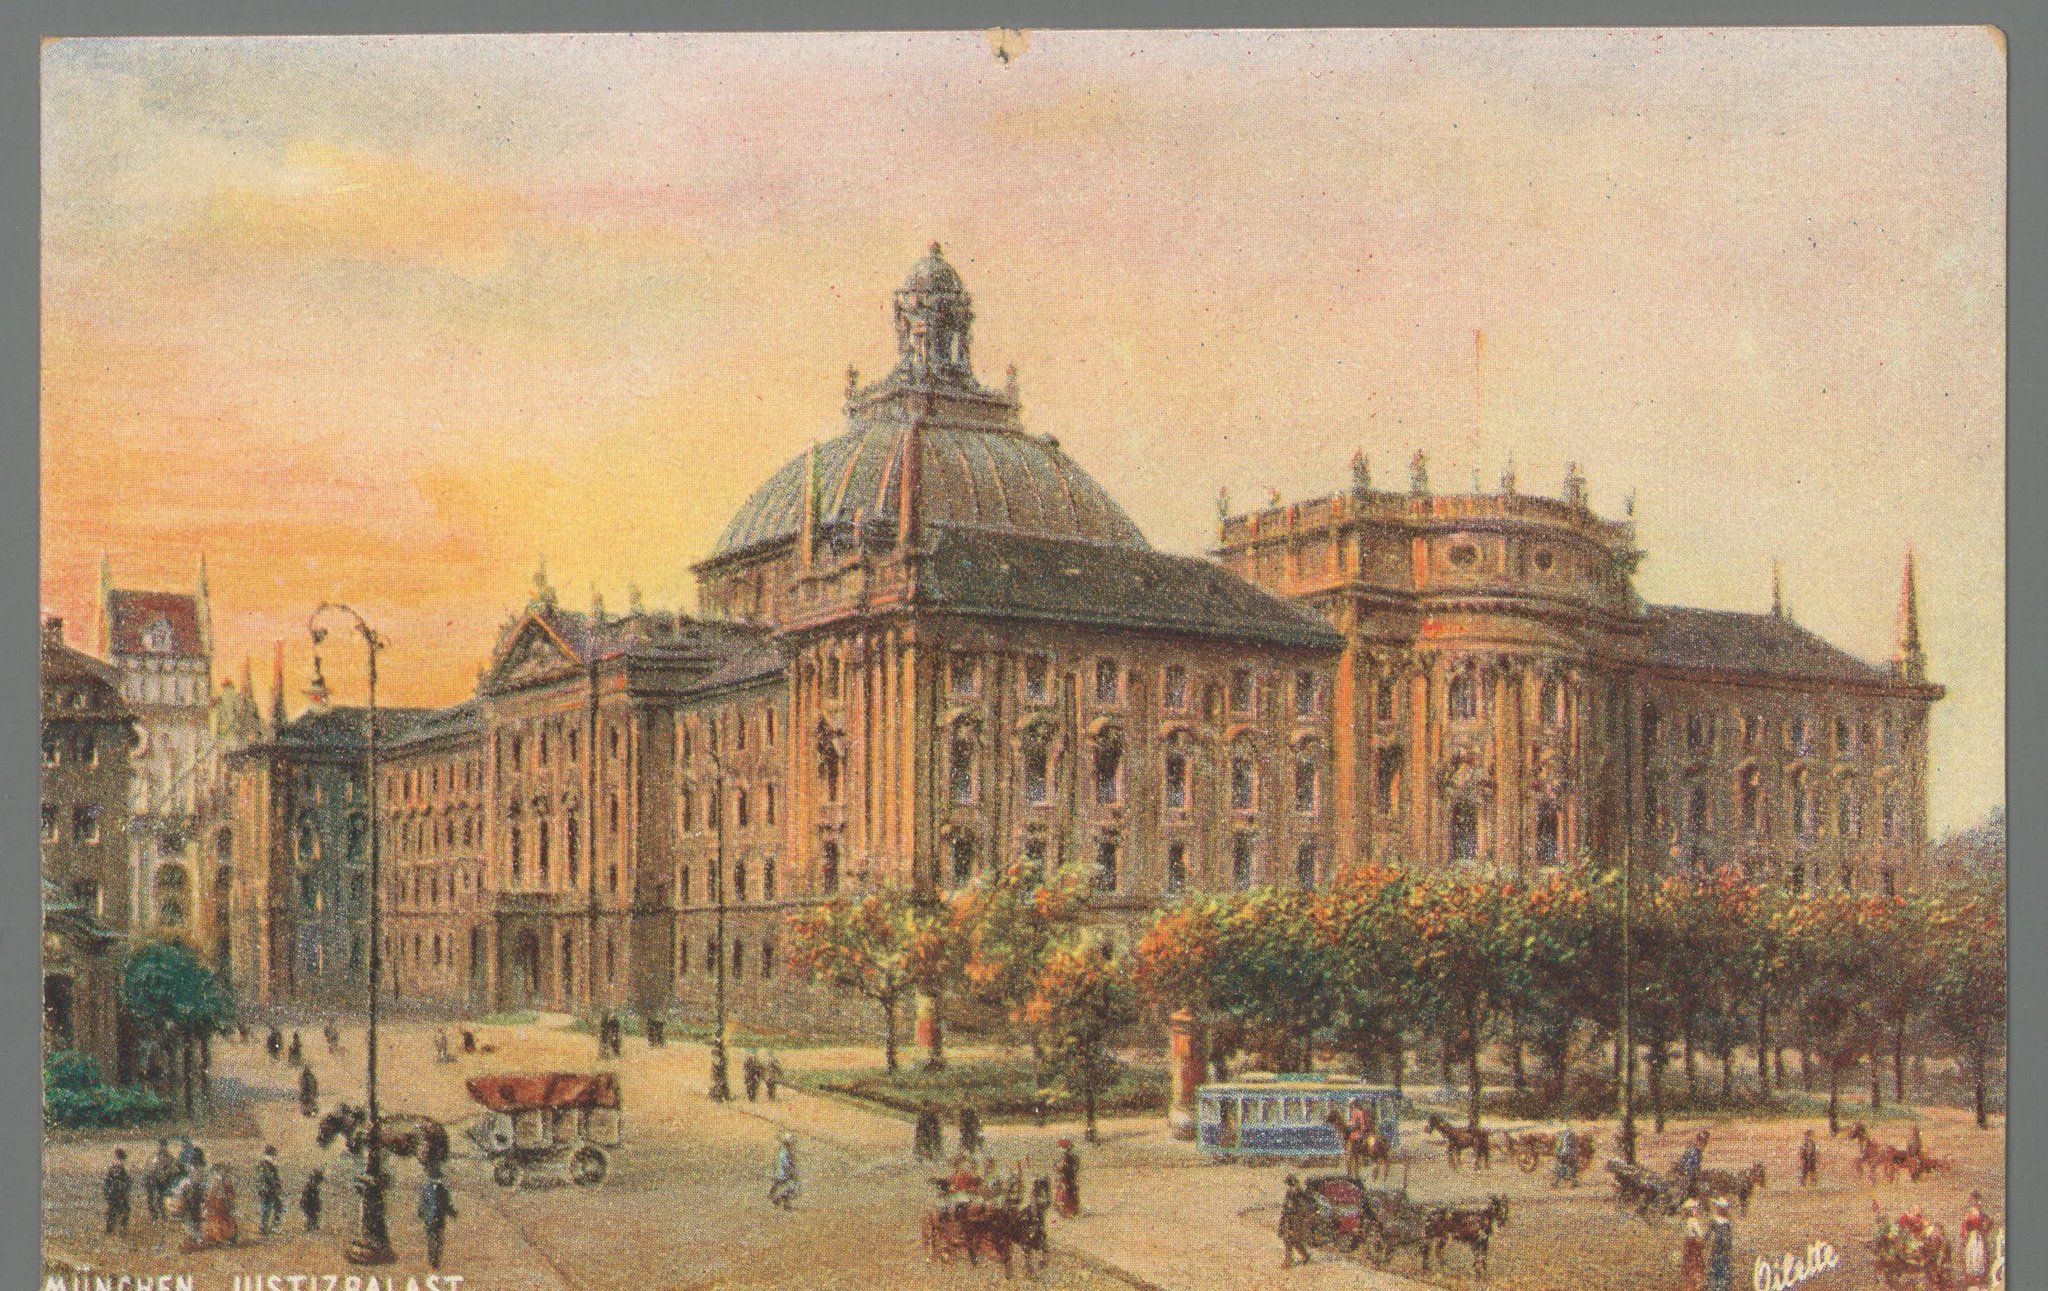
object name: ansichtkaart, prentbriefkaart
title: Oilette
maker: Anonymous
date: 1906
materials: cardboard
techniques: writing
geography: berlin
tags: court building